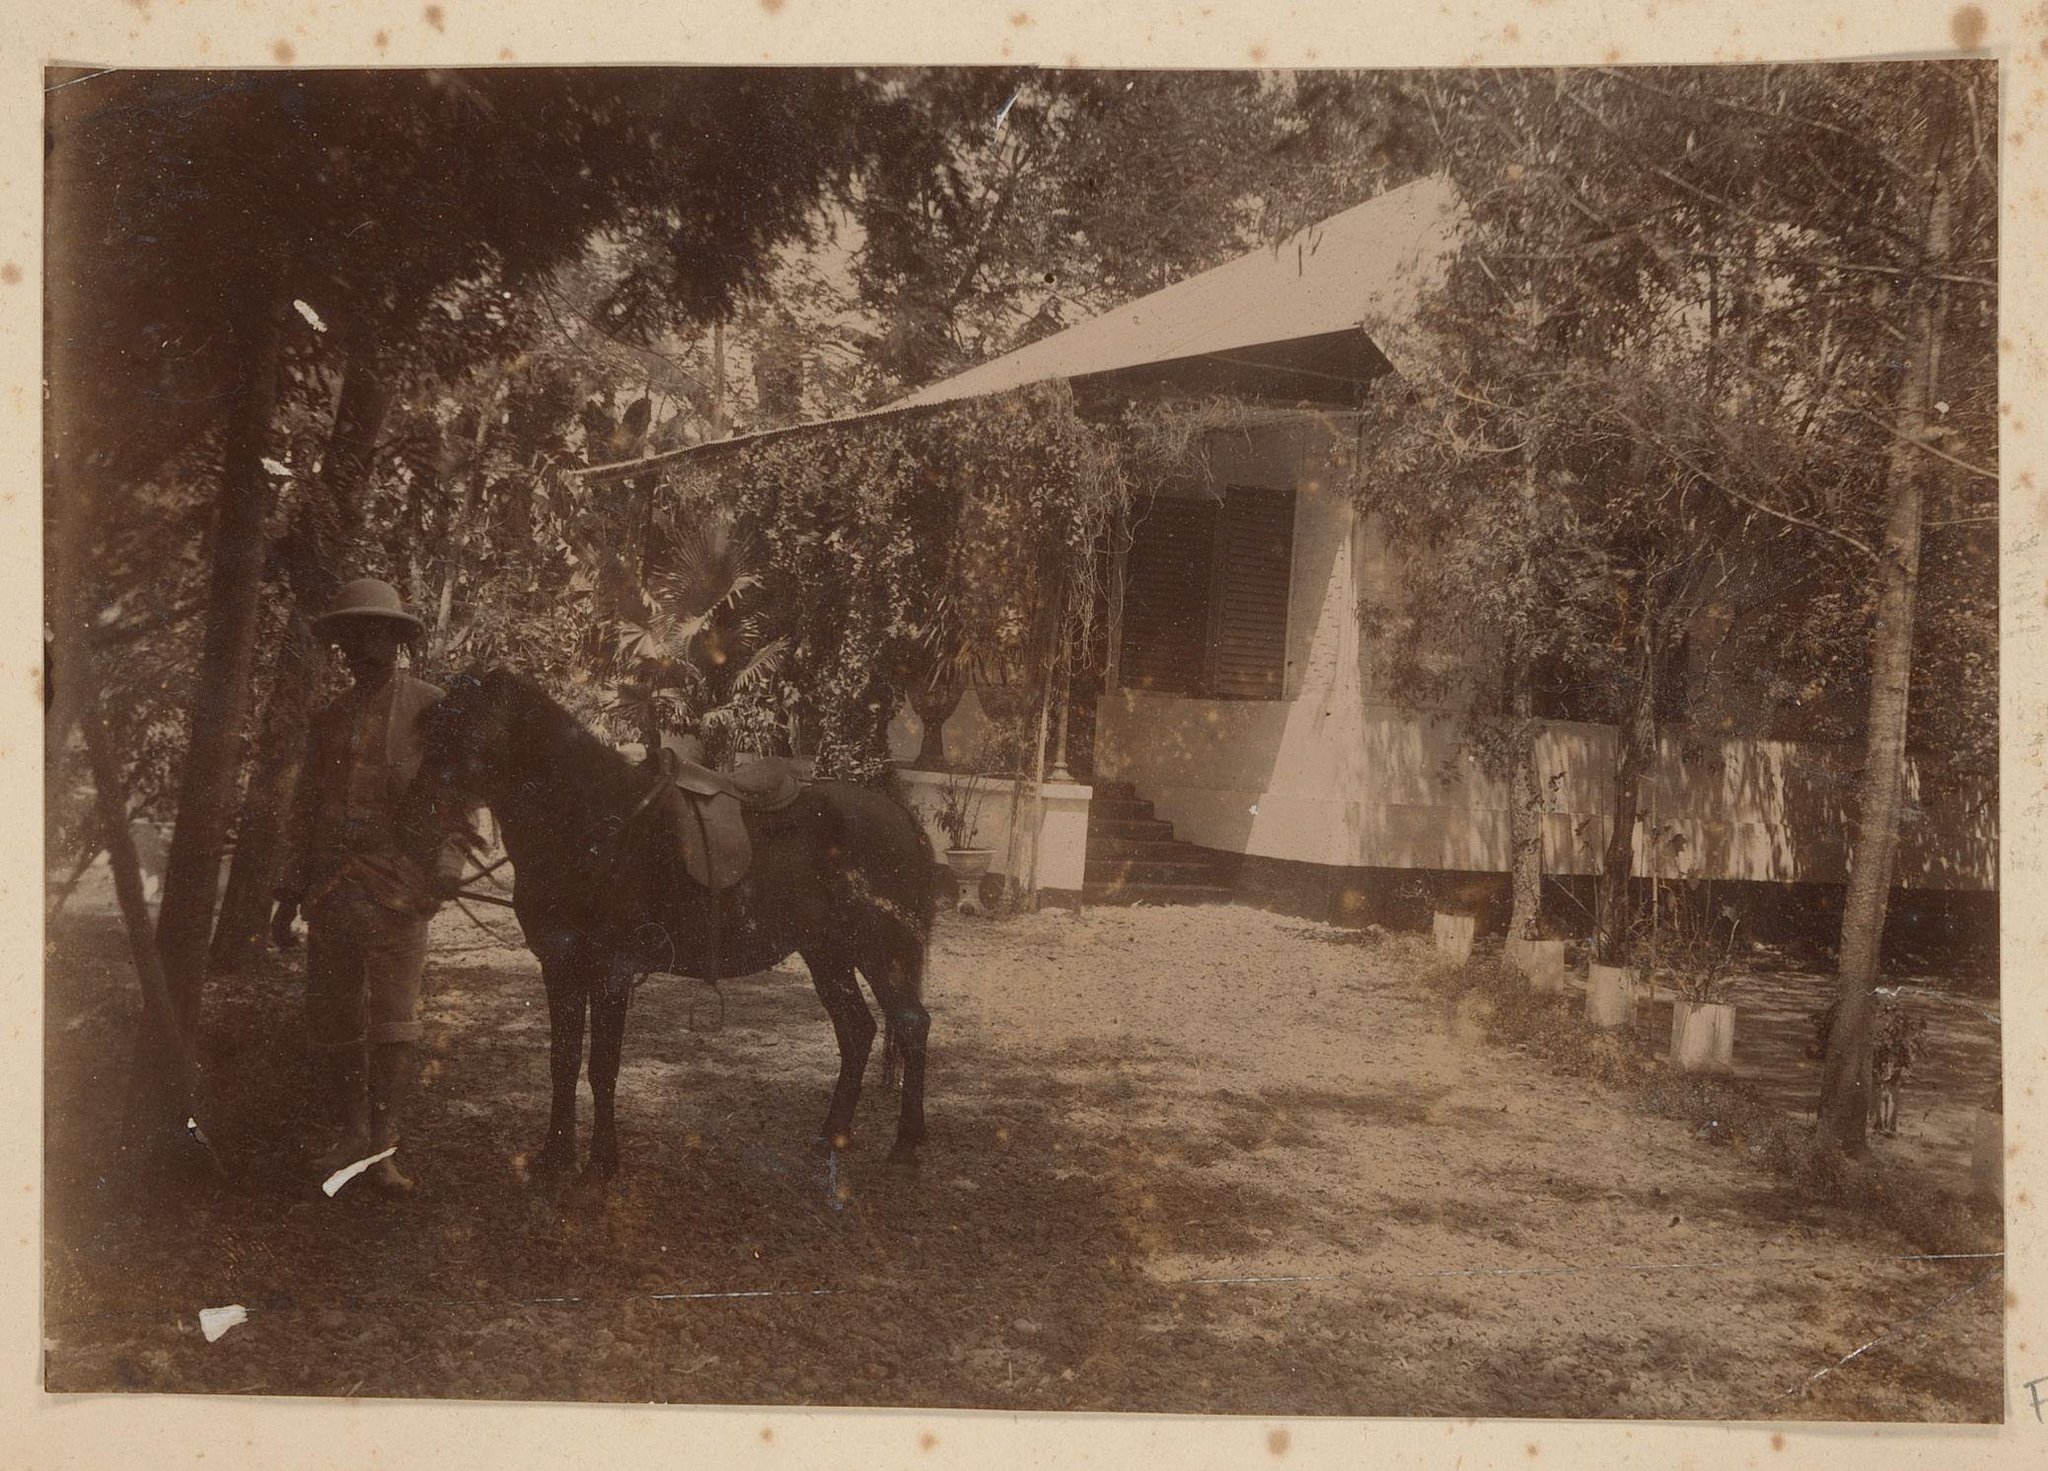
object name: photograph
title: Man met paard in een tuin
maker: Anonymous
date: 1890-1910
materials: photographic support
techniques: daylight paper print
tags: garden, historical persons, horse, dutch east indies, the